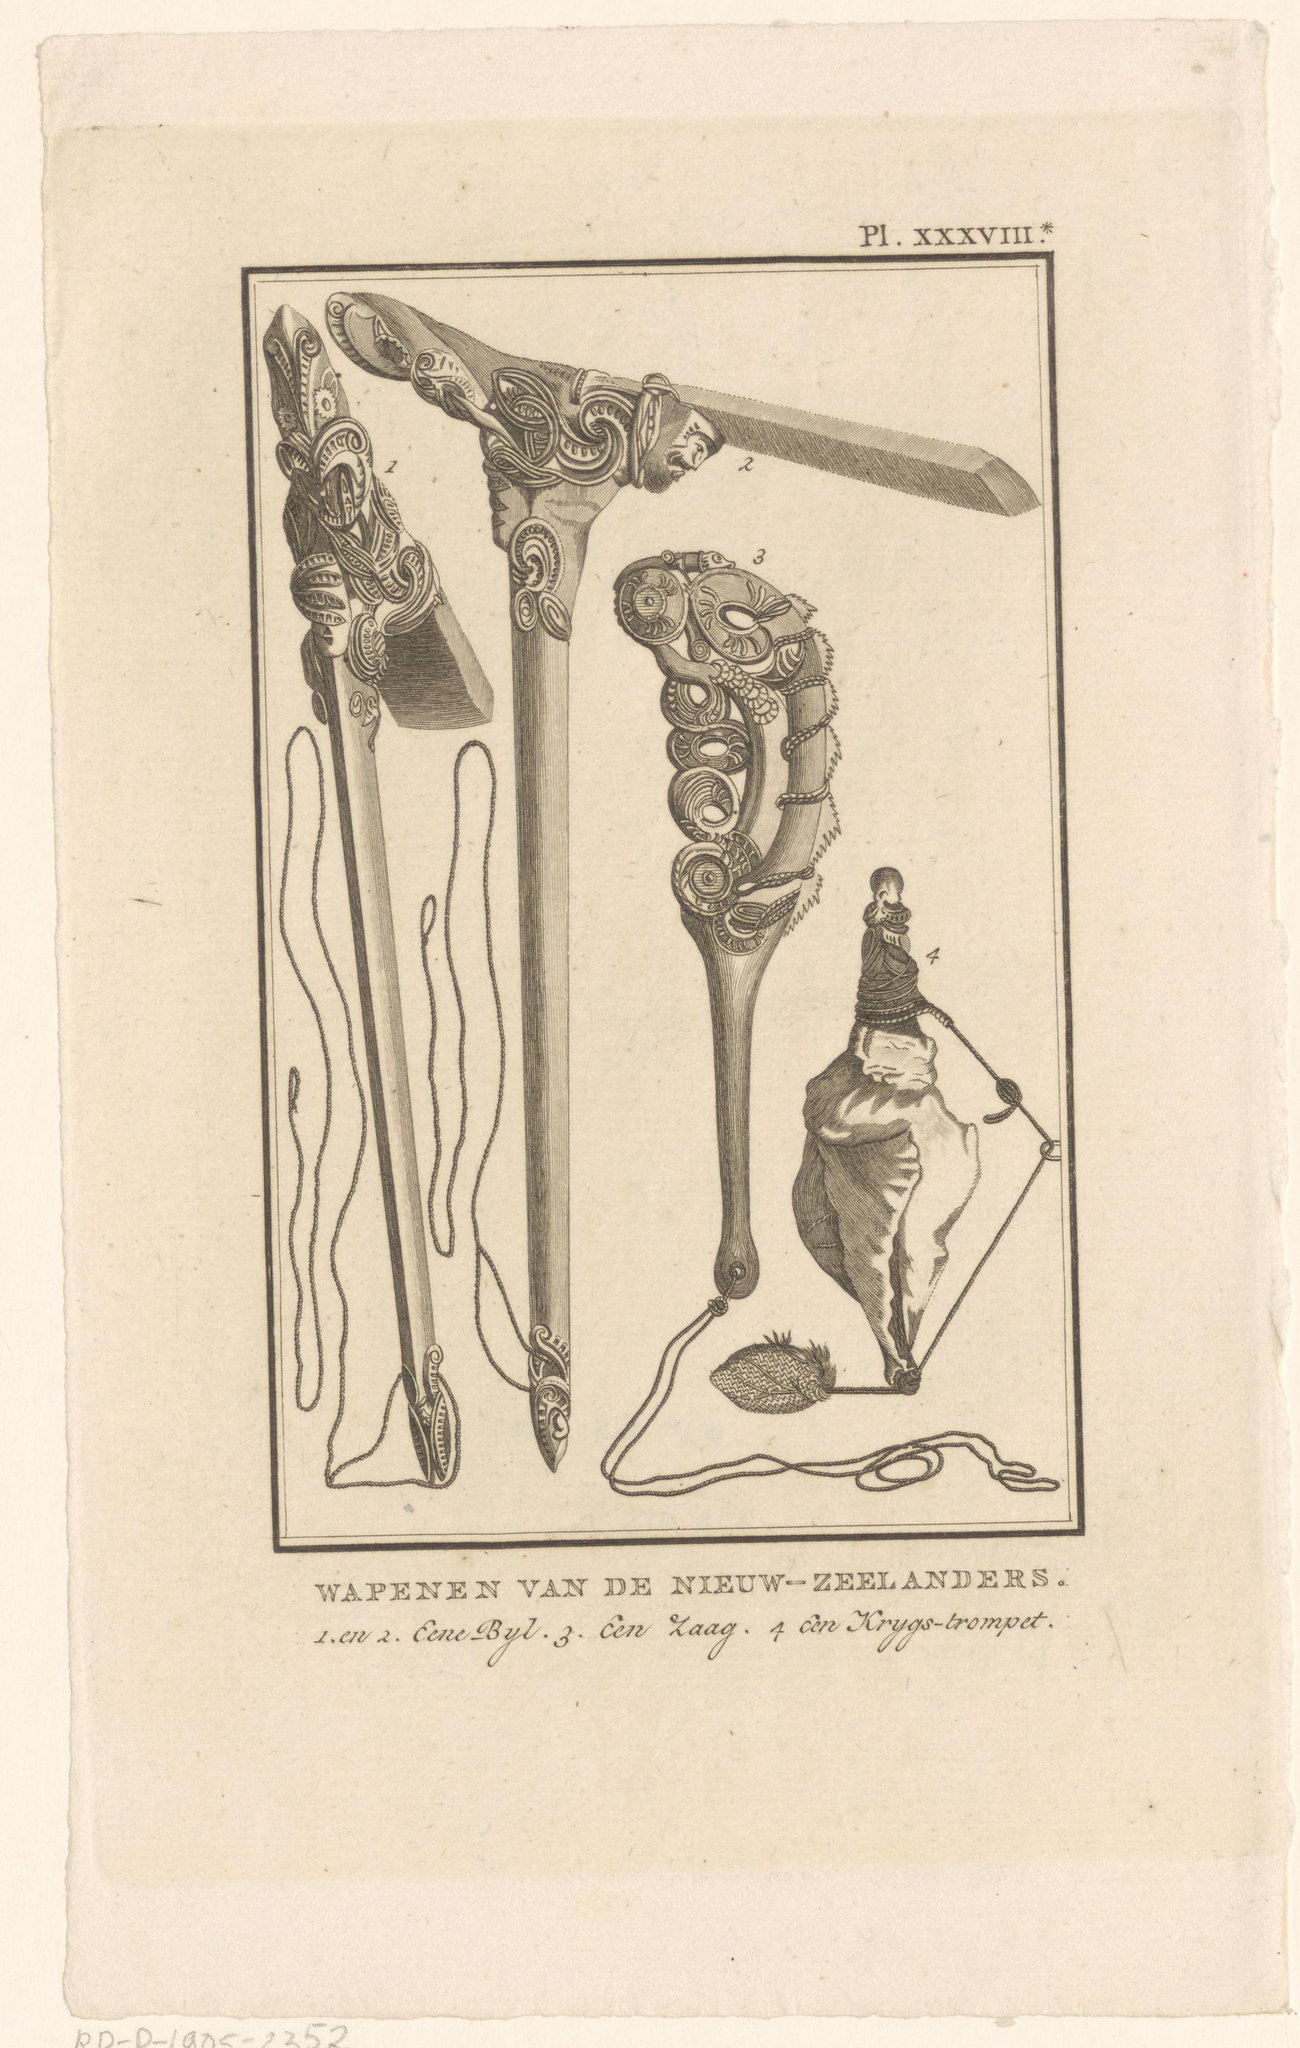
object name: print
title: Wapens gemaakt door de oorspronkelijke bewoners van Nieuw-Zeeland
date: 1795-1803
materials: paper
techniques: engraving, etching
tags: hacking and thrusting weapons, horn, trumpet, cornet, trombone, tuba, helved weapons, polearms (for striking, hacking, thrusting), tools, aids, implements ~ crafts and industries: saw, new zealand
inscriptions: collector's mark: Lugt 2228, number: ‘XXXVIII’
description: De prent is gebruikt in: Cook, James. Reize rondom de Waereld (...) met kaarten en plaaten. [Vertaald uit het Engels door] Jan David Pasteur. Leiden: Honkoop, Amsterdam: Allart, Den Haag: Van Cleef, 1795-1803, dl. 13.